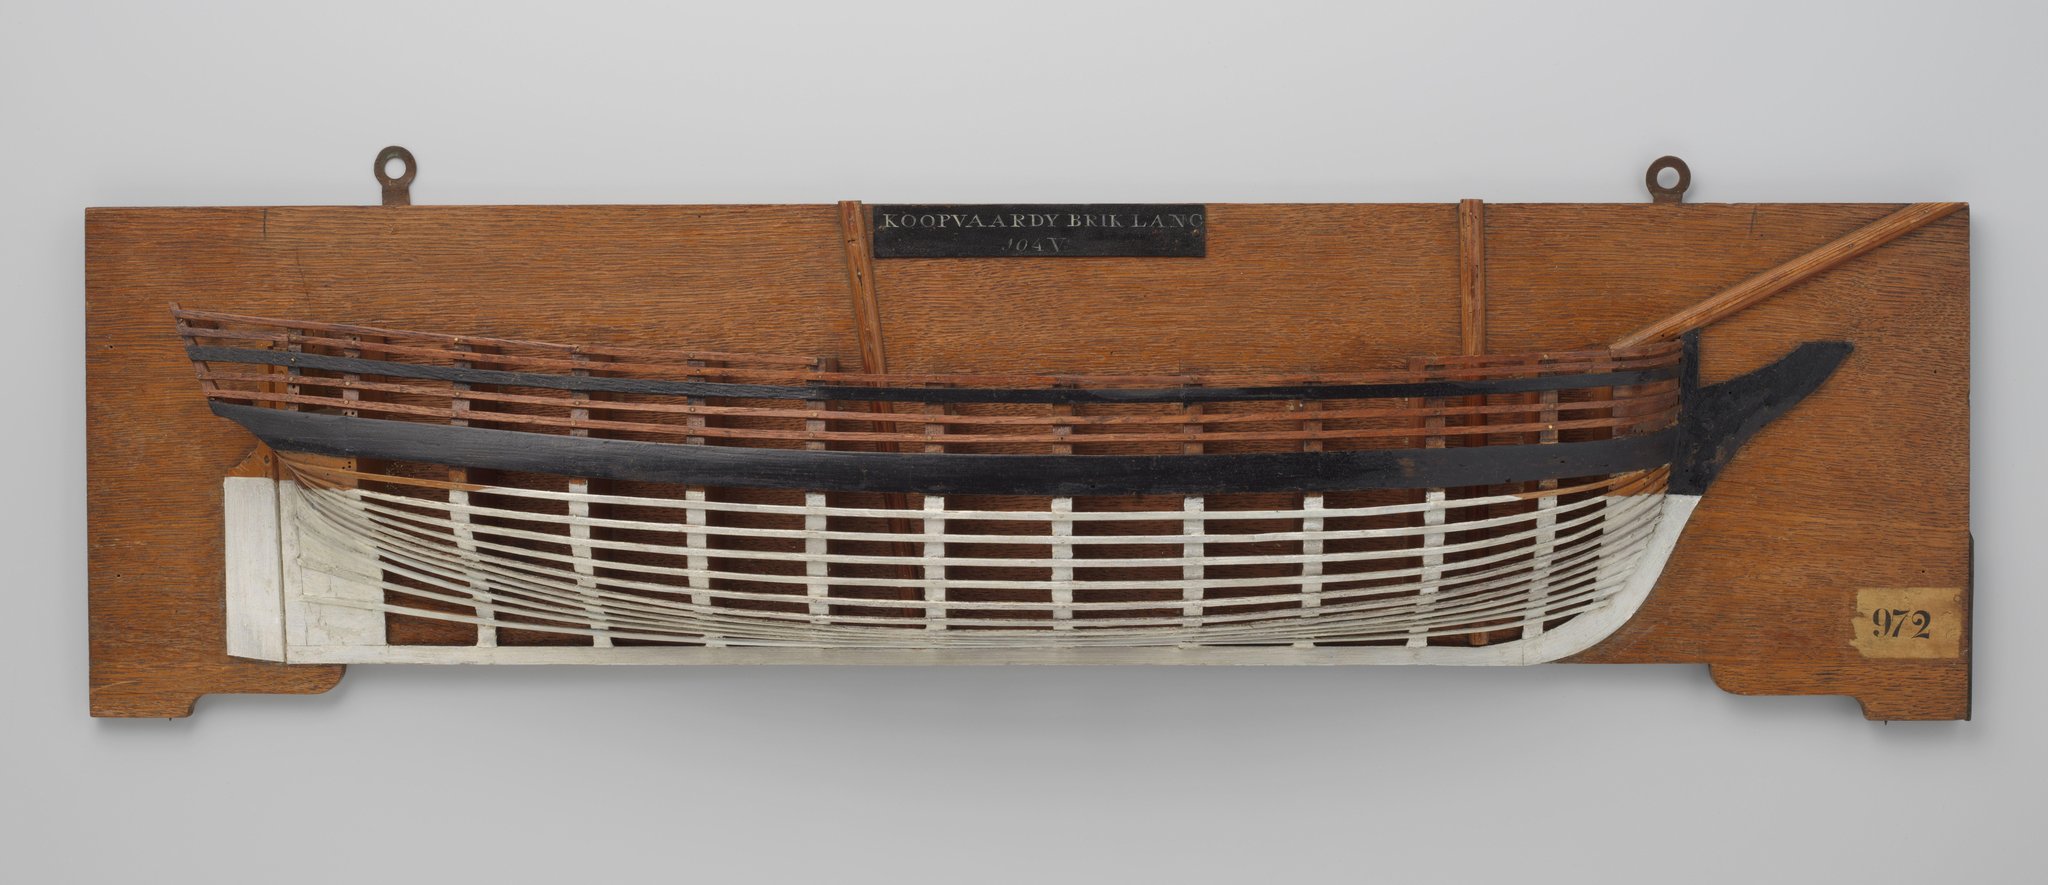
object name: half model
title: Half Model of a Merchantman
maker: Anonymous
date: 1780-1820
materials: wood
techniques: polychromy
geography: netherlands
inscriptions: inscription, top centre, on a rectangular black label: ‘KOOPVAARDY BRIK LANG / 104 Vt’, label, bottom right: ‘972’ former inventory label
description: Gepolychromeerd mallenmodel (stuurboord) van een tweemaster. Geen dekken of geschutpoorten aangegeven. Gewrongen spiegel, hol wulf, geen details van hek of zijgalerij; recht roer met vierkante roerkoning, de achtersteven loopt hoog door in de wulf. Zeeg naar voren en naar achter oplopend, één barkhout en één reehout. Gepiekt rondspant. Schaal ca. 1:48 (afgeleid).